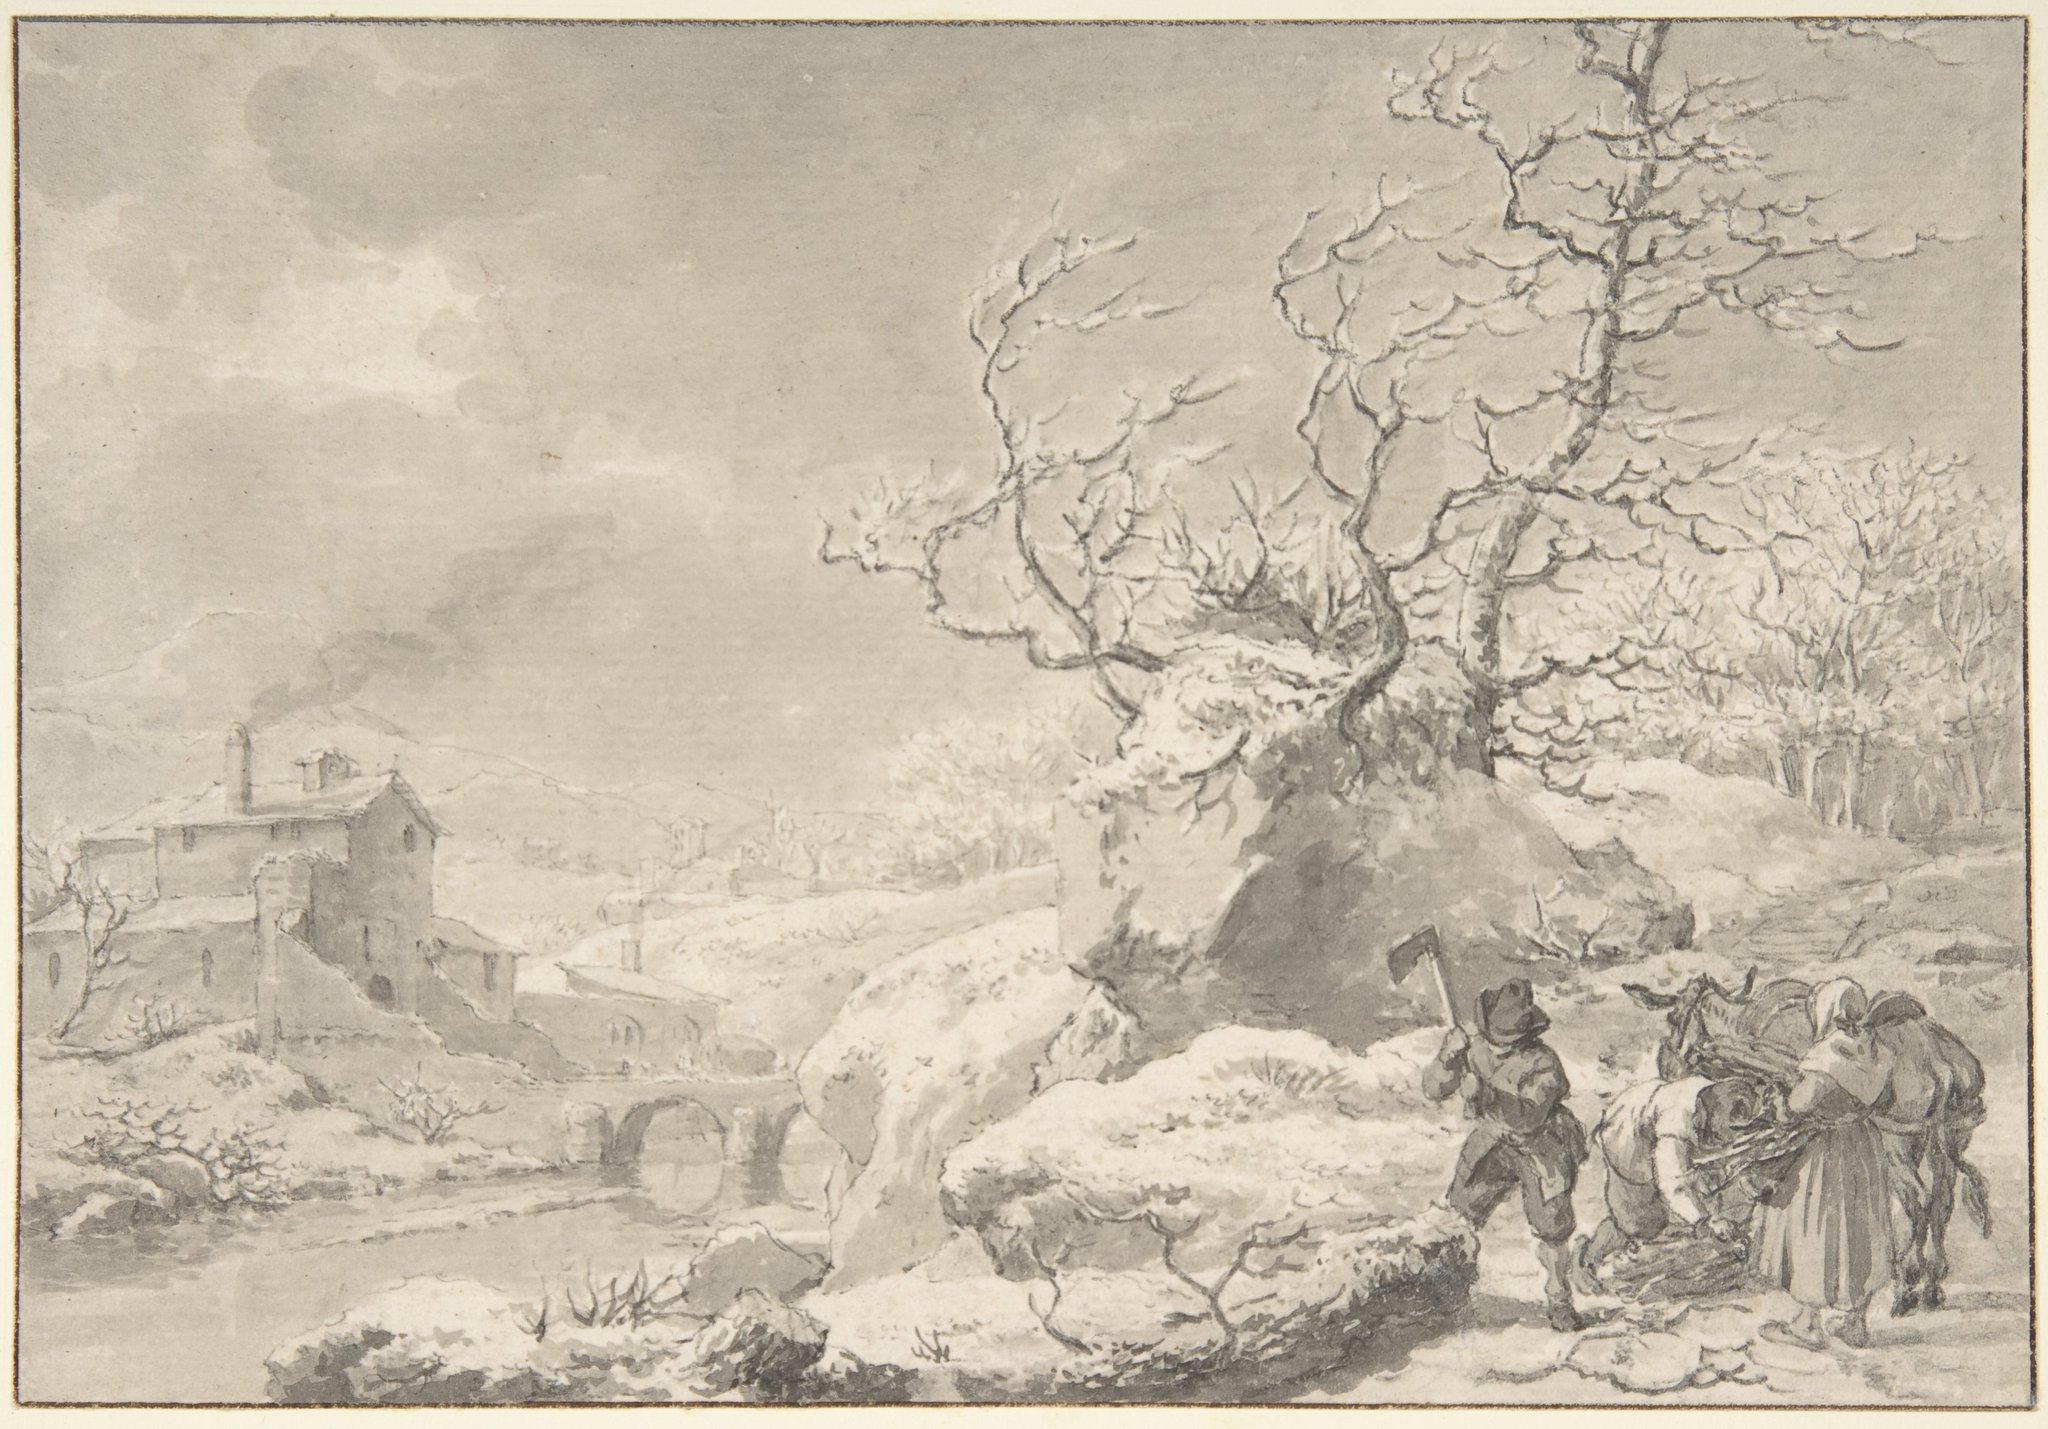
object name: drawing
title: Winter Landscape with Peasants Gathering and Chopping Wood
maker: jacob cats (1741-1799)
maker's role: artist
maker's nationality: dutch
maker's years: 1741-1799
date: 1784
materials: chalk, ink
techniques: brush, pen, wash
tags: human figures,landscapes,trees,winter,snow